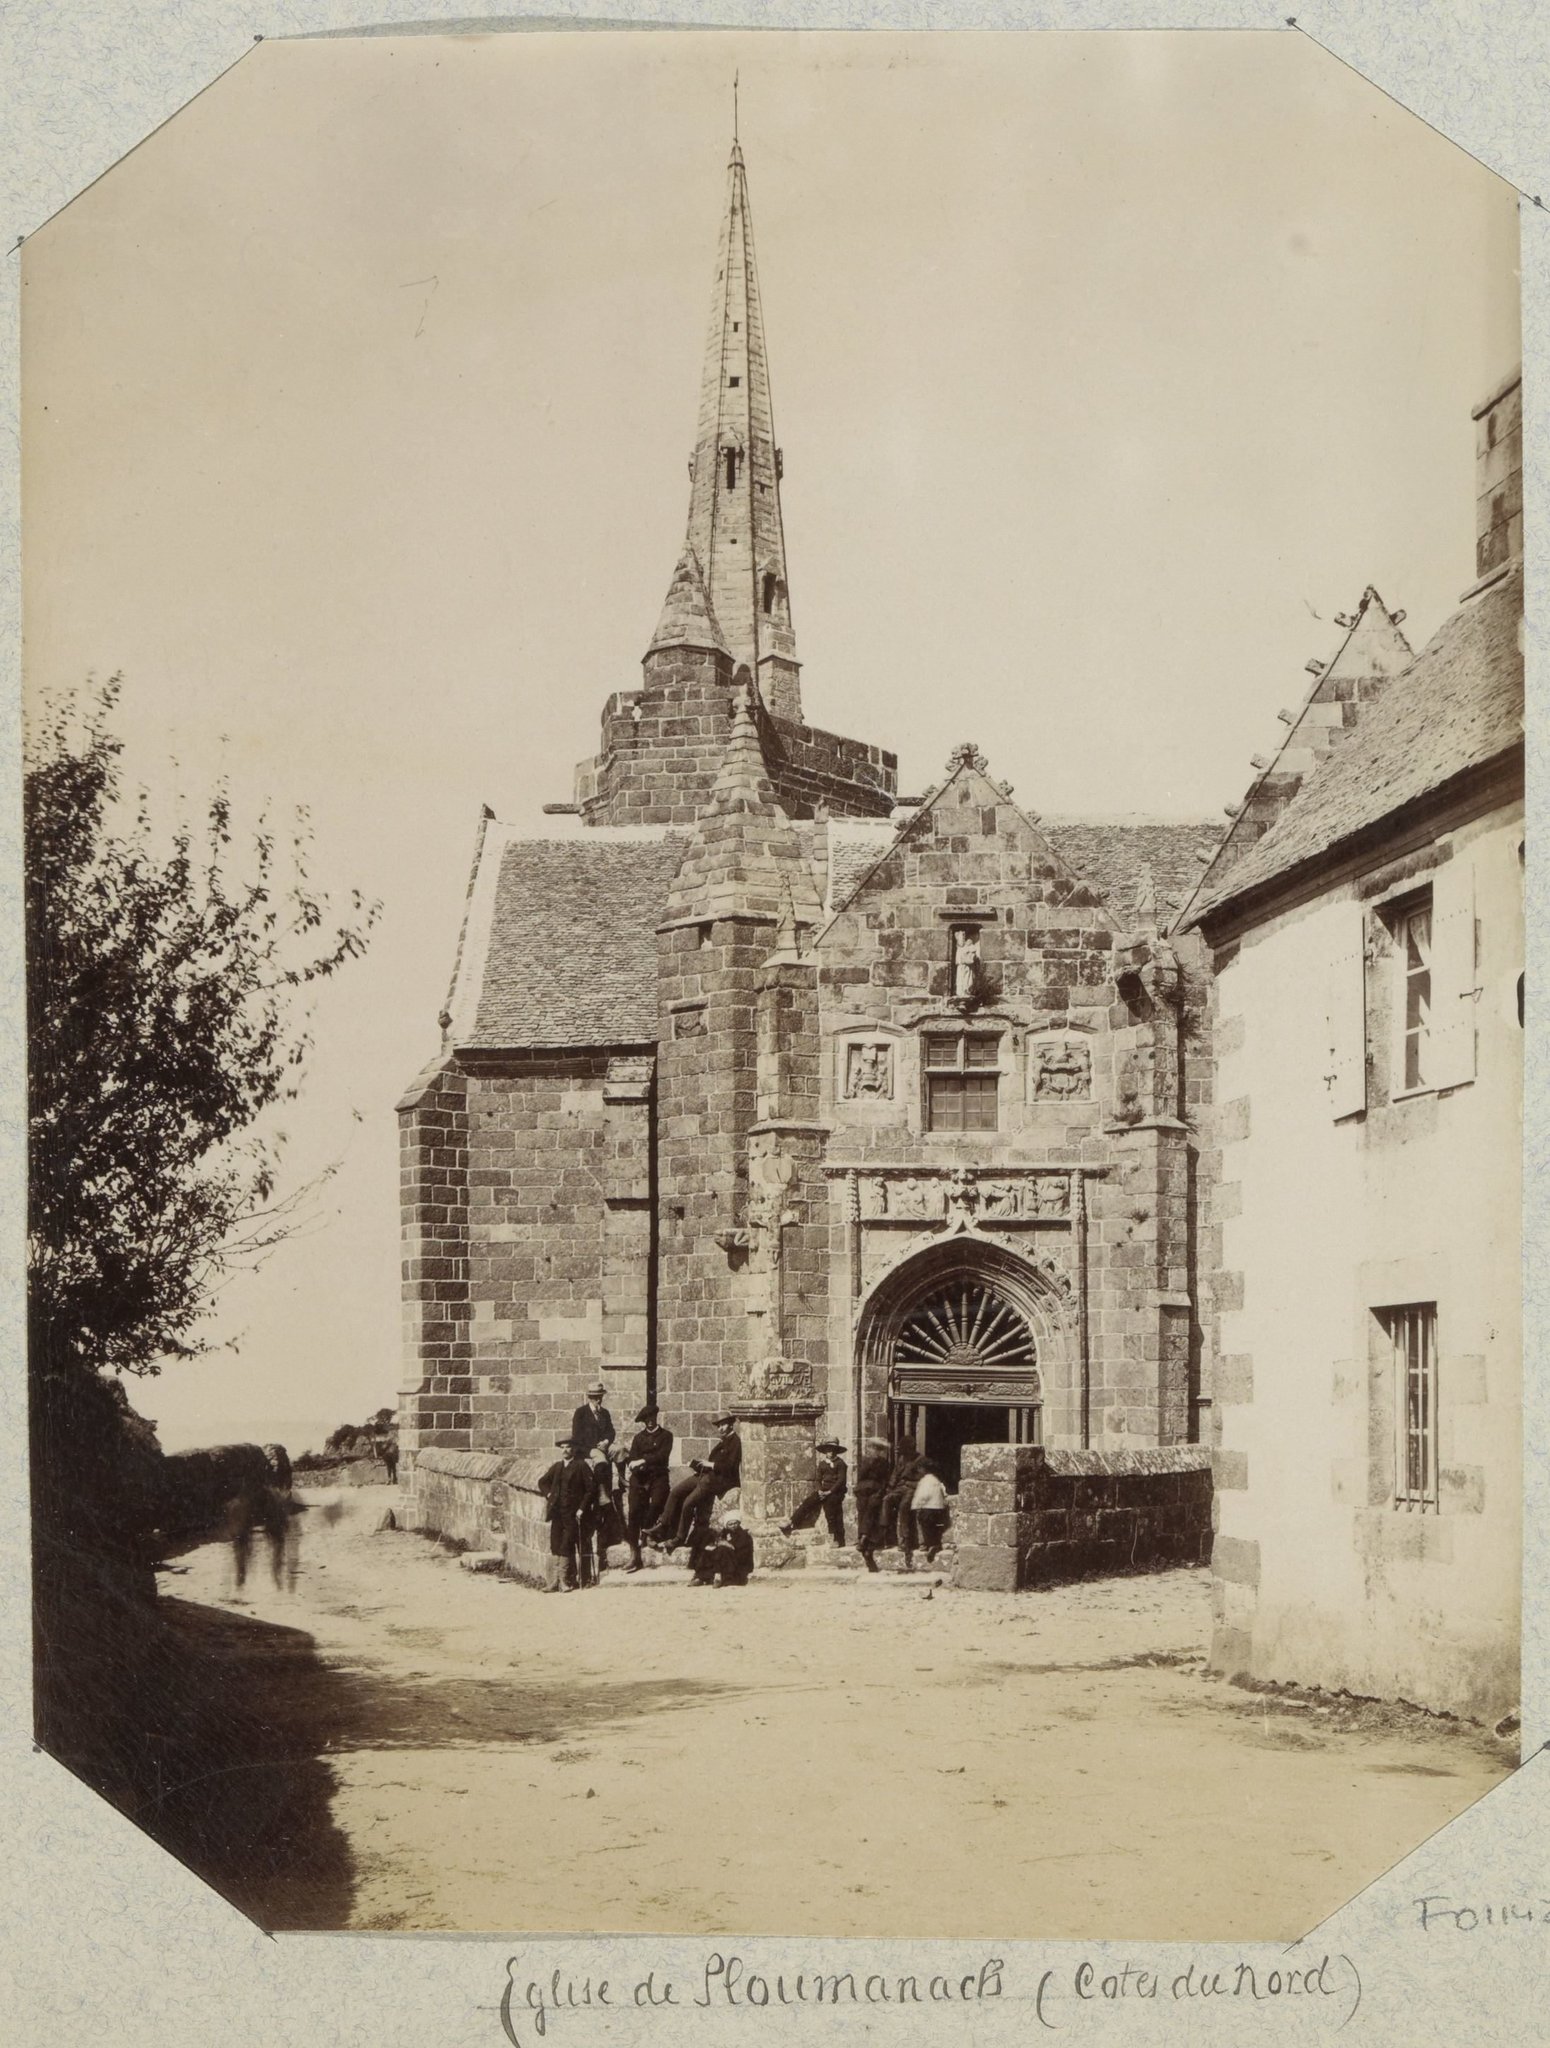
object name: album leaf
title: Groep mannen poserend voor de Kapel van de Notre-Dame-de-la-Clarté in Perros Ploumanach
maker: Anonymous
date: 1880-1900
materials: paper, photographic support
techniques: albumen print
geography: ploumanach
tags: church (exterior), parts of church exterior and annexes: tower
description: Onderdeel van Album van een Franse amateur met foto's van Frankrijk, Algerije, Palmyra, de Wereldtentoonstelling van 1900 en van bekende Fransen.